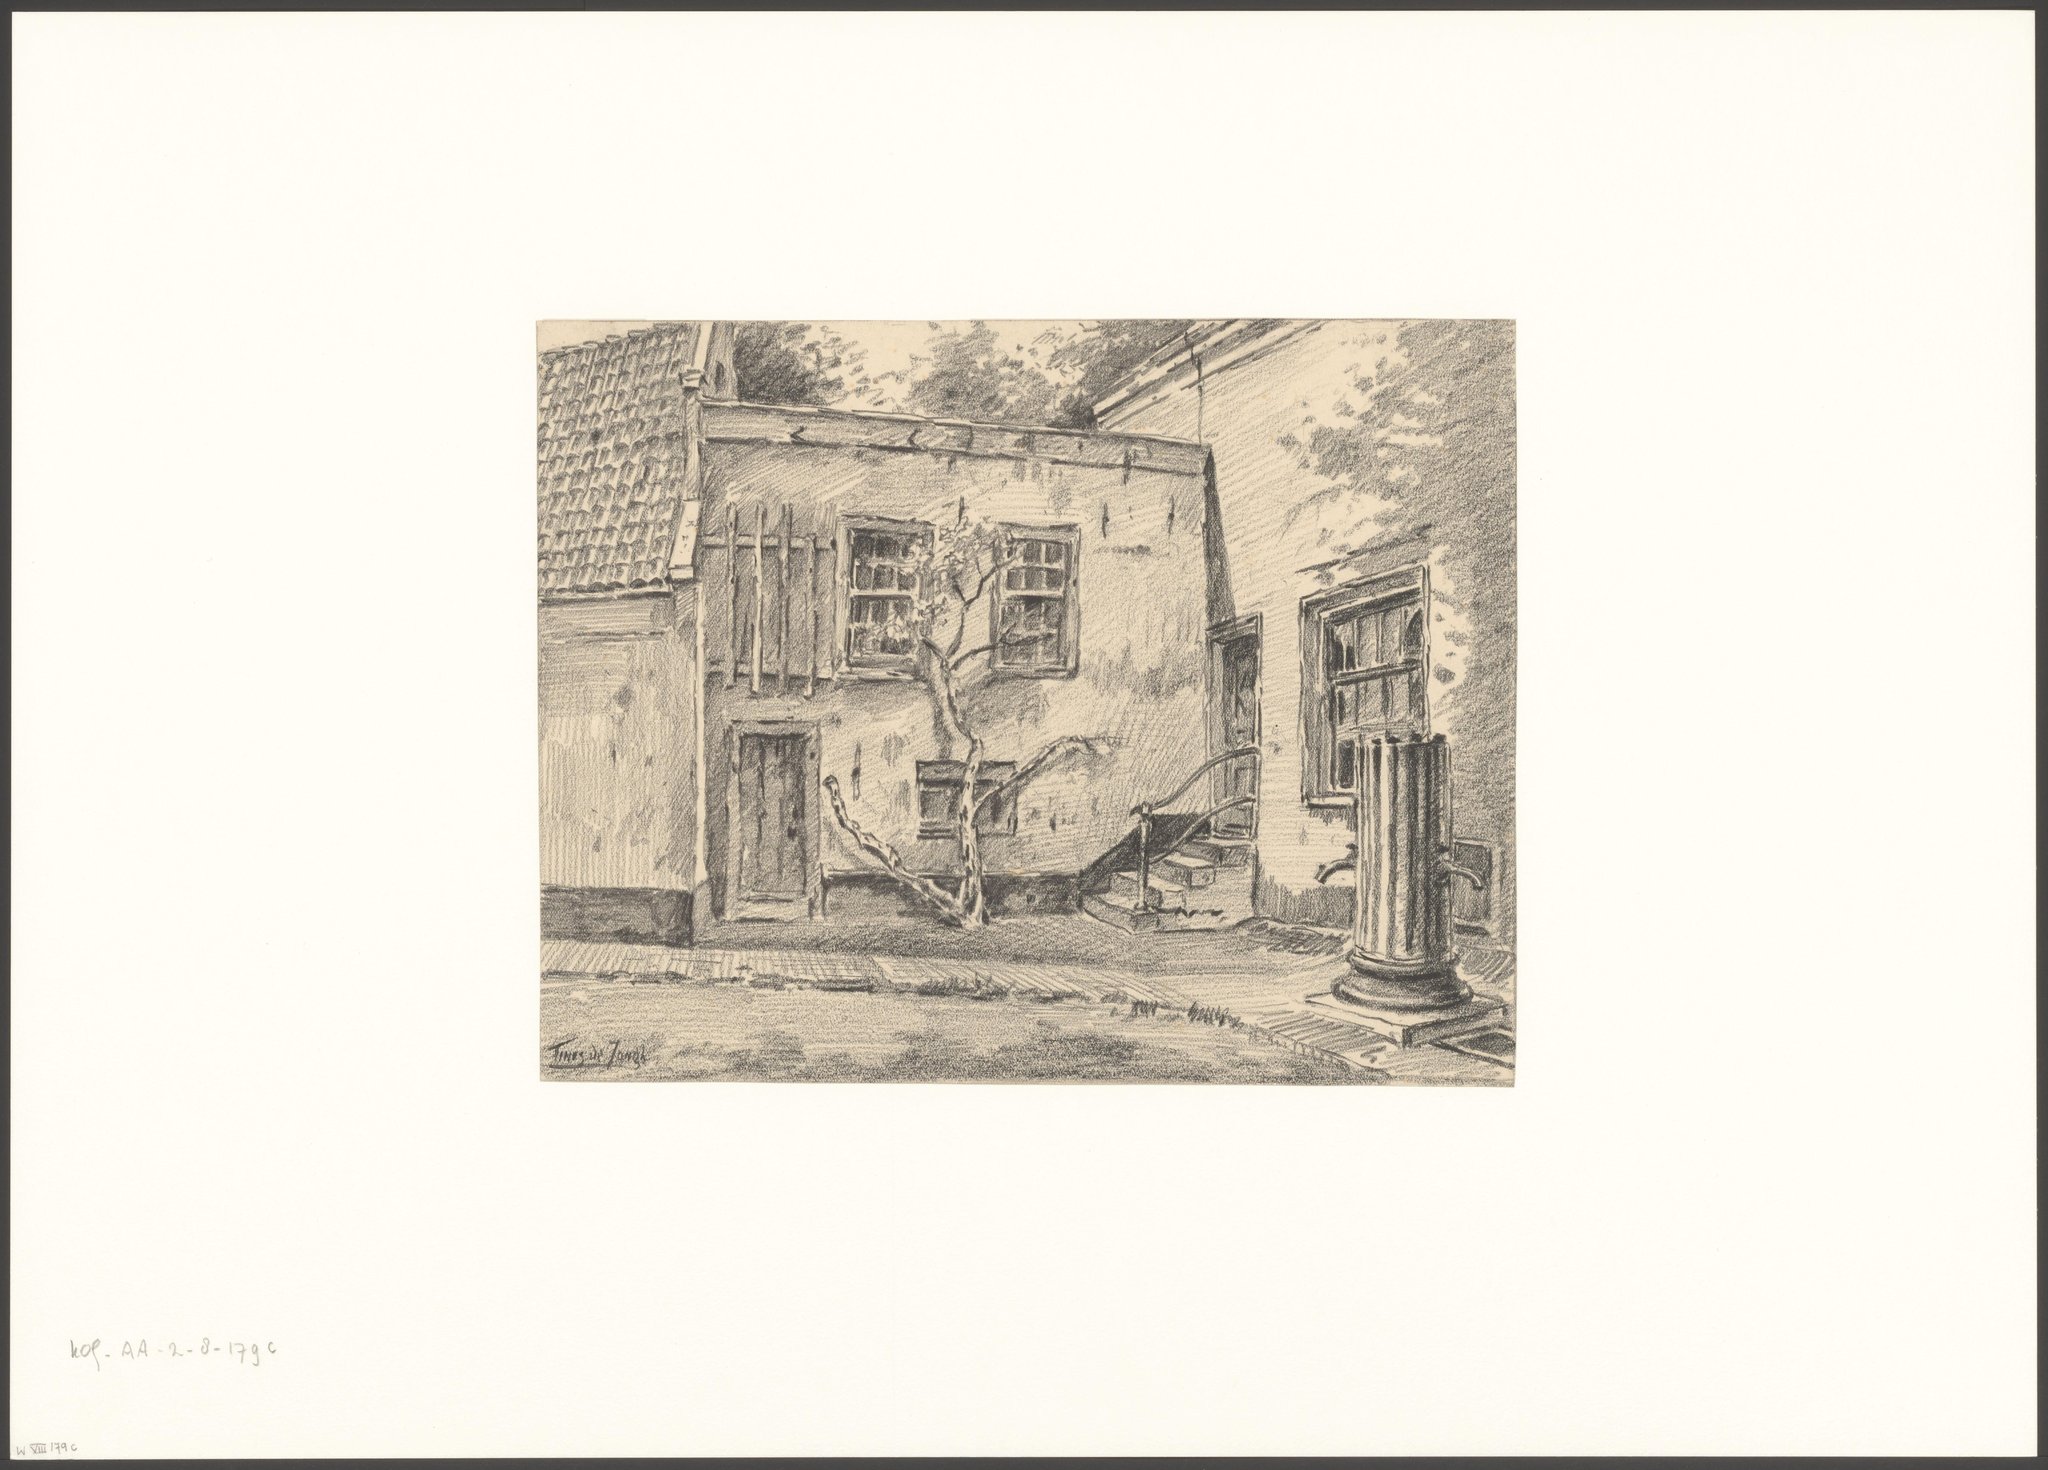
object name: drawing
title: Gezicht op buitenplaats Amstelvliet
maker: tinus de jongh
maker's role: print maker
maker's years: 1885-1942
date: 1919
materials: chalk, paper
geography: amsterdam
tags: city-view in general; 'veduta', road, path, farm or solitary house in landscape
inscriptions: signature and date: ‘"TinusdeJongh" / 1919’, inscription: ‘achterzijde Amstelvliet / heeren huis a/d Amsteldijk’, signature: ‘TinusdeJongh’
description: Tekening binnen de Atlas Van Eck ingedeeld op wijknummer 8.